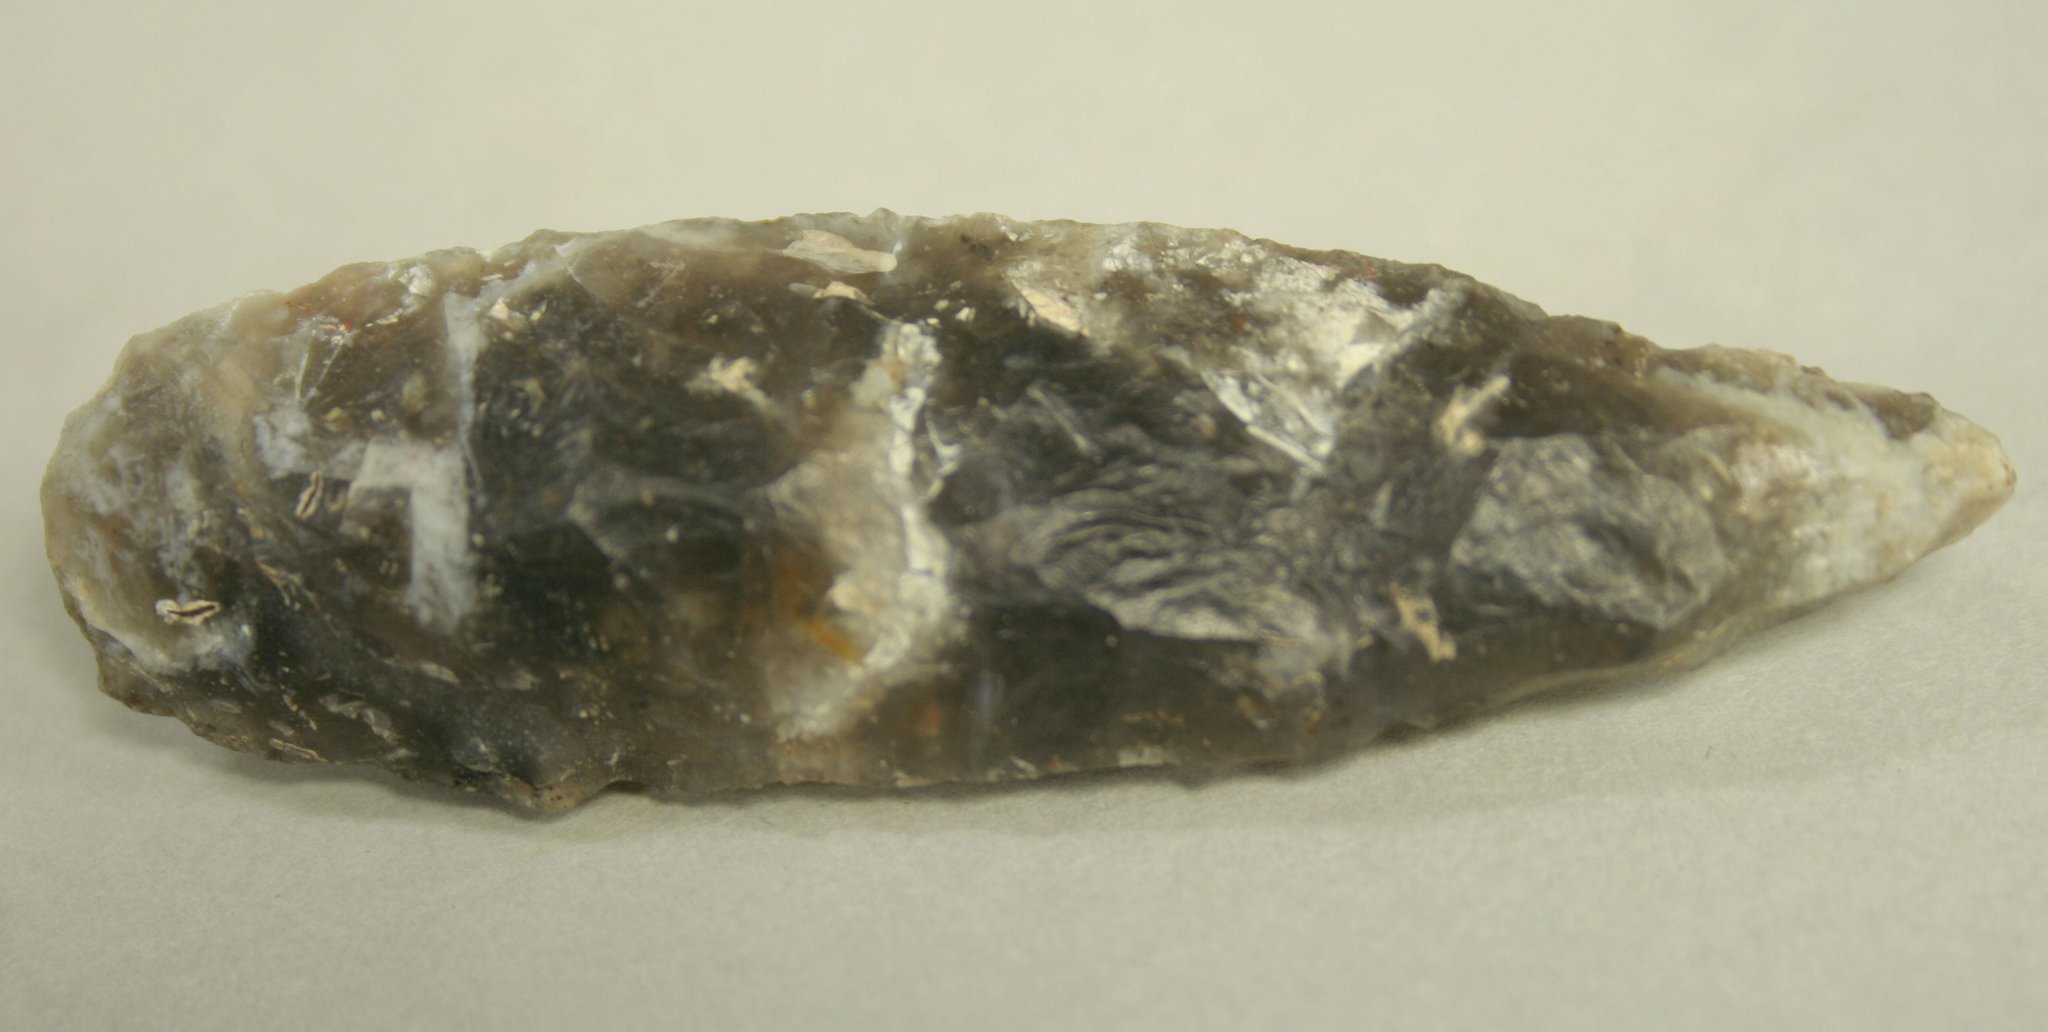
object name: knife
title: Point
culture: valdivia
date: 3000-2001 BCE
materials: obsidian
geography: ecuador